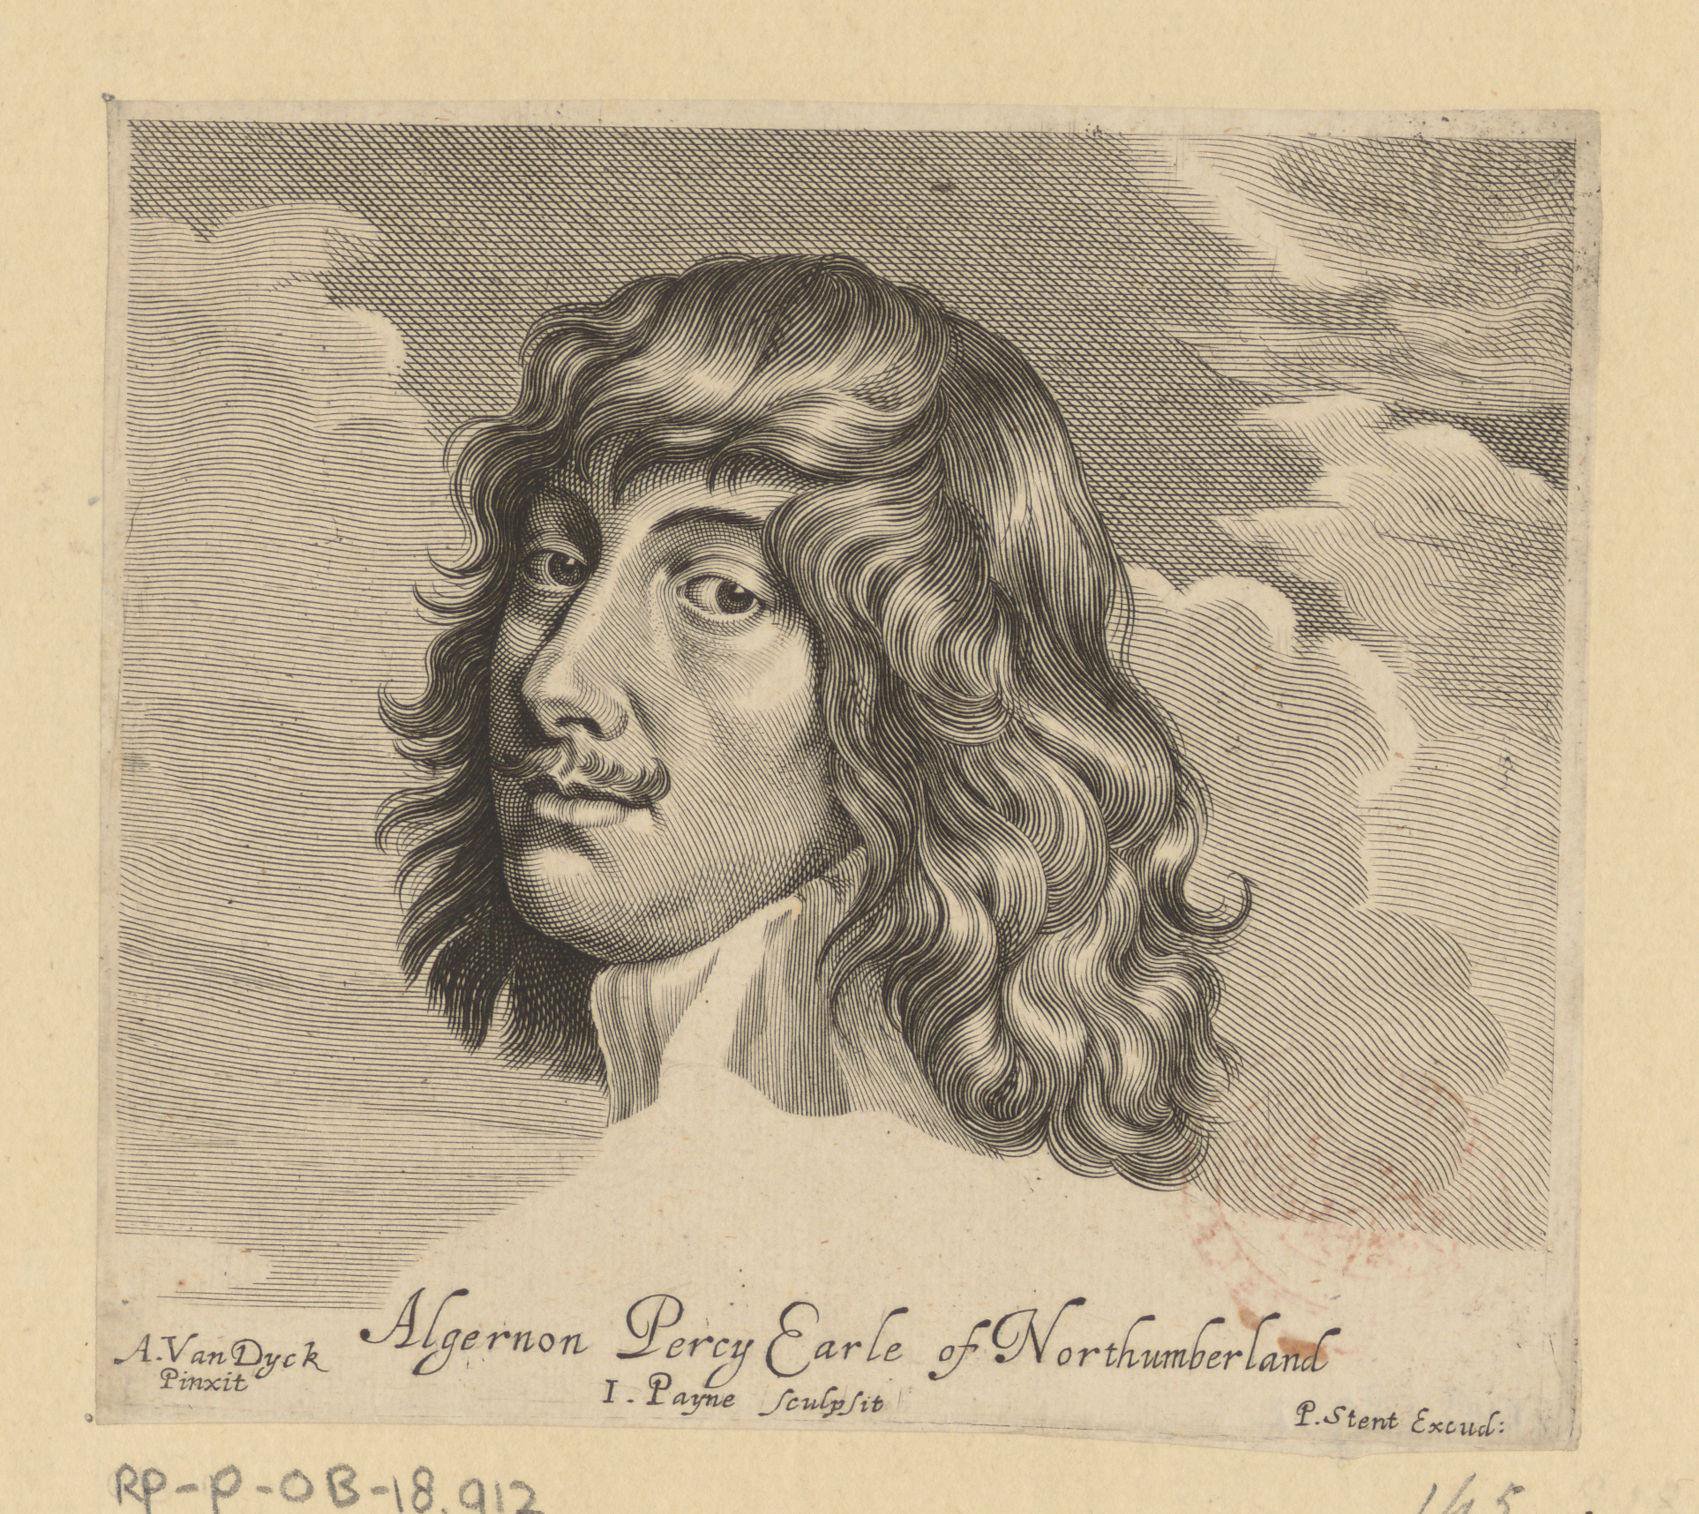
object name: print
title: Portret van Algernon Percy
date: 1642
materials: paper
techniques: engraving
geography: london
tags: commander-in-chief, general, marshal, historical persons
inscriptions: collector's mark: Lugt 240